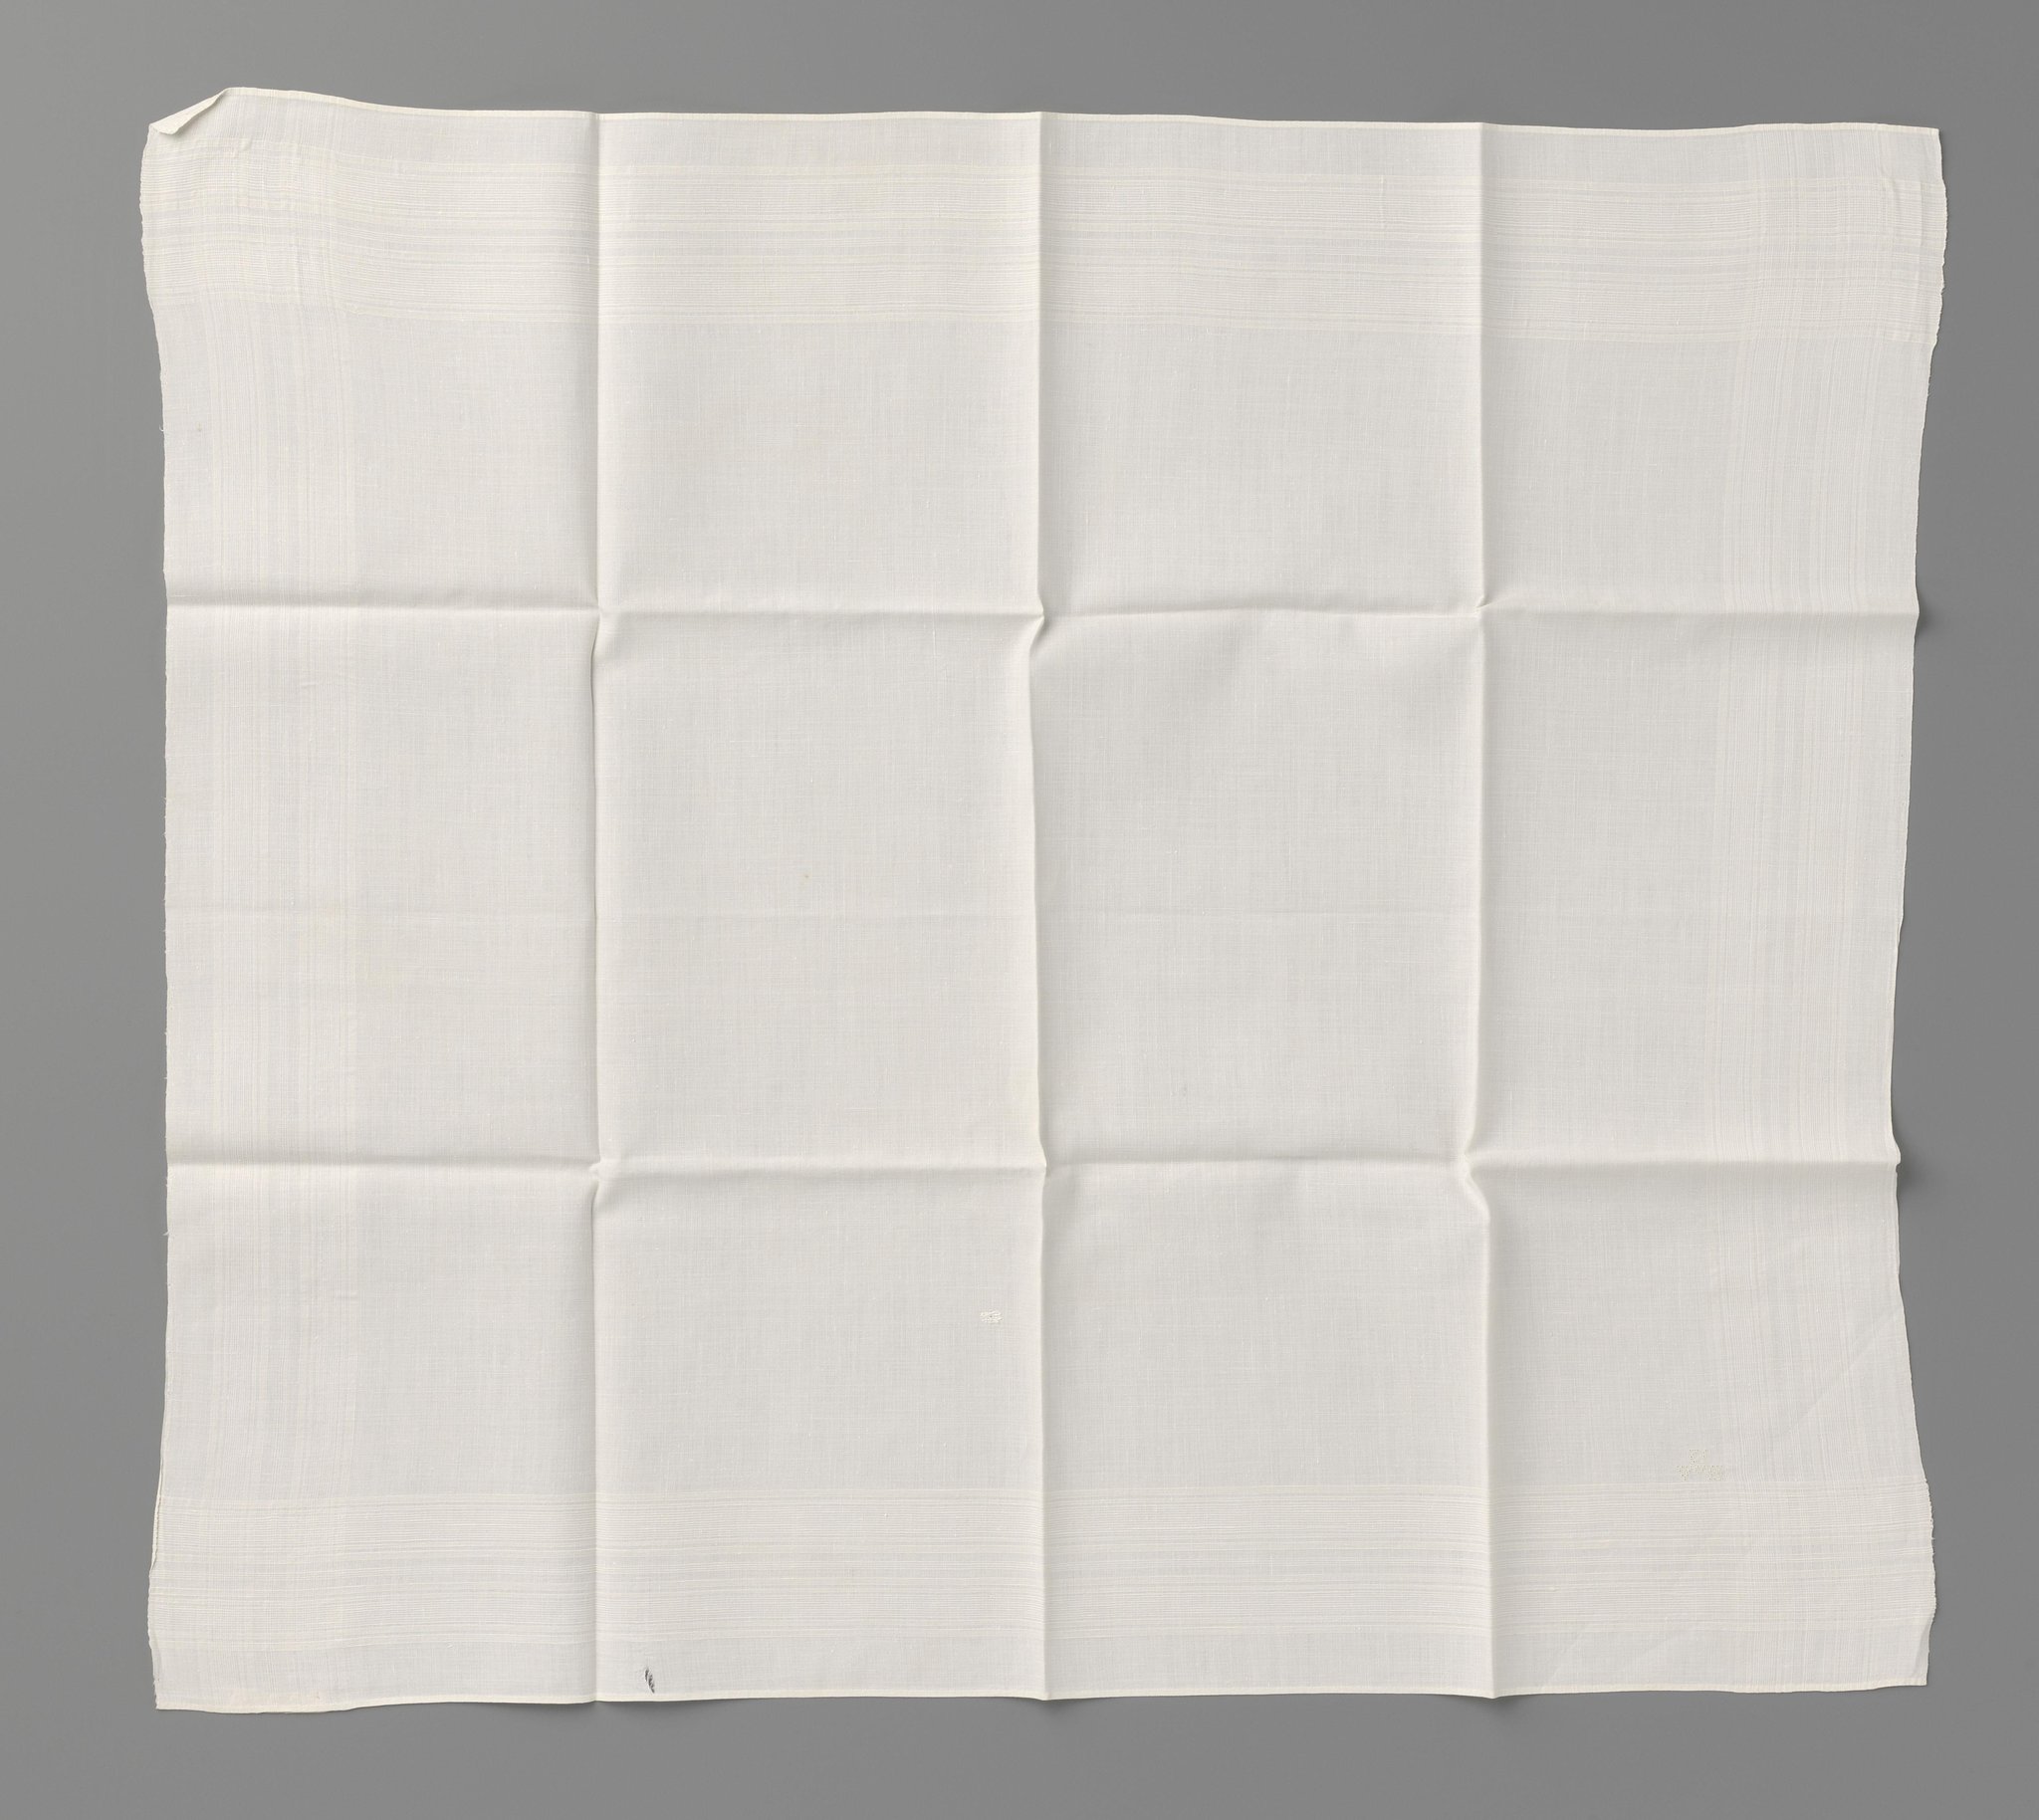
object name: clothing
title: Zakdoek van wit linnen met brede rand van ingeweven randbiezen; met gaatjesmerk: HdA/12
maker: Anonymous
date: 1840-1880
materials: linen, silk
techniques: embroidered, weave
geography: netherlands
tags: leiden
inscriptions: mark: ‘HdA/12’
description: De bijgevoegde handgeschreven notitie van freule C.I. Six doet vermoeden dat het om mannenzakdoeken gaat. Echter, er is geen baron d'Ablaing van Giessenburg bekend met als initiaal 'H'. Waarschijnlijk zijn ze afkomstig van Henriëtte Louise Elisabeth barones d'Ablaing van Giessenburg (1837-1872), die in 1860 trouwt met Jhr. Pieter Hendrik Six, heer van Vromade. Hun dochter jkvr. Louise D.C. Six (1862-1934) sterft kinderloos en na het overlijden van haar echtgenoot, F.E. Blaauw wordt hun inboedel in 1939 geveild. Freule C.I. Six kocht een aantal stukken uit deze inboedel.